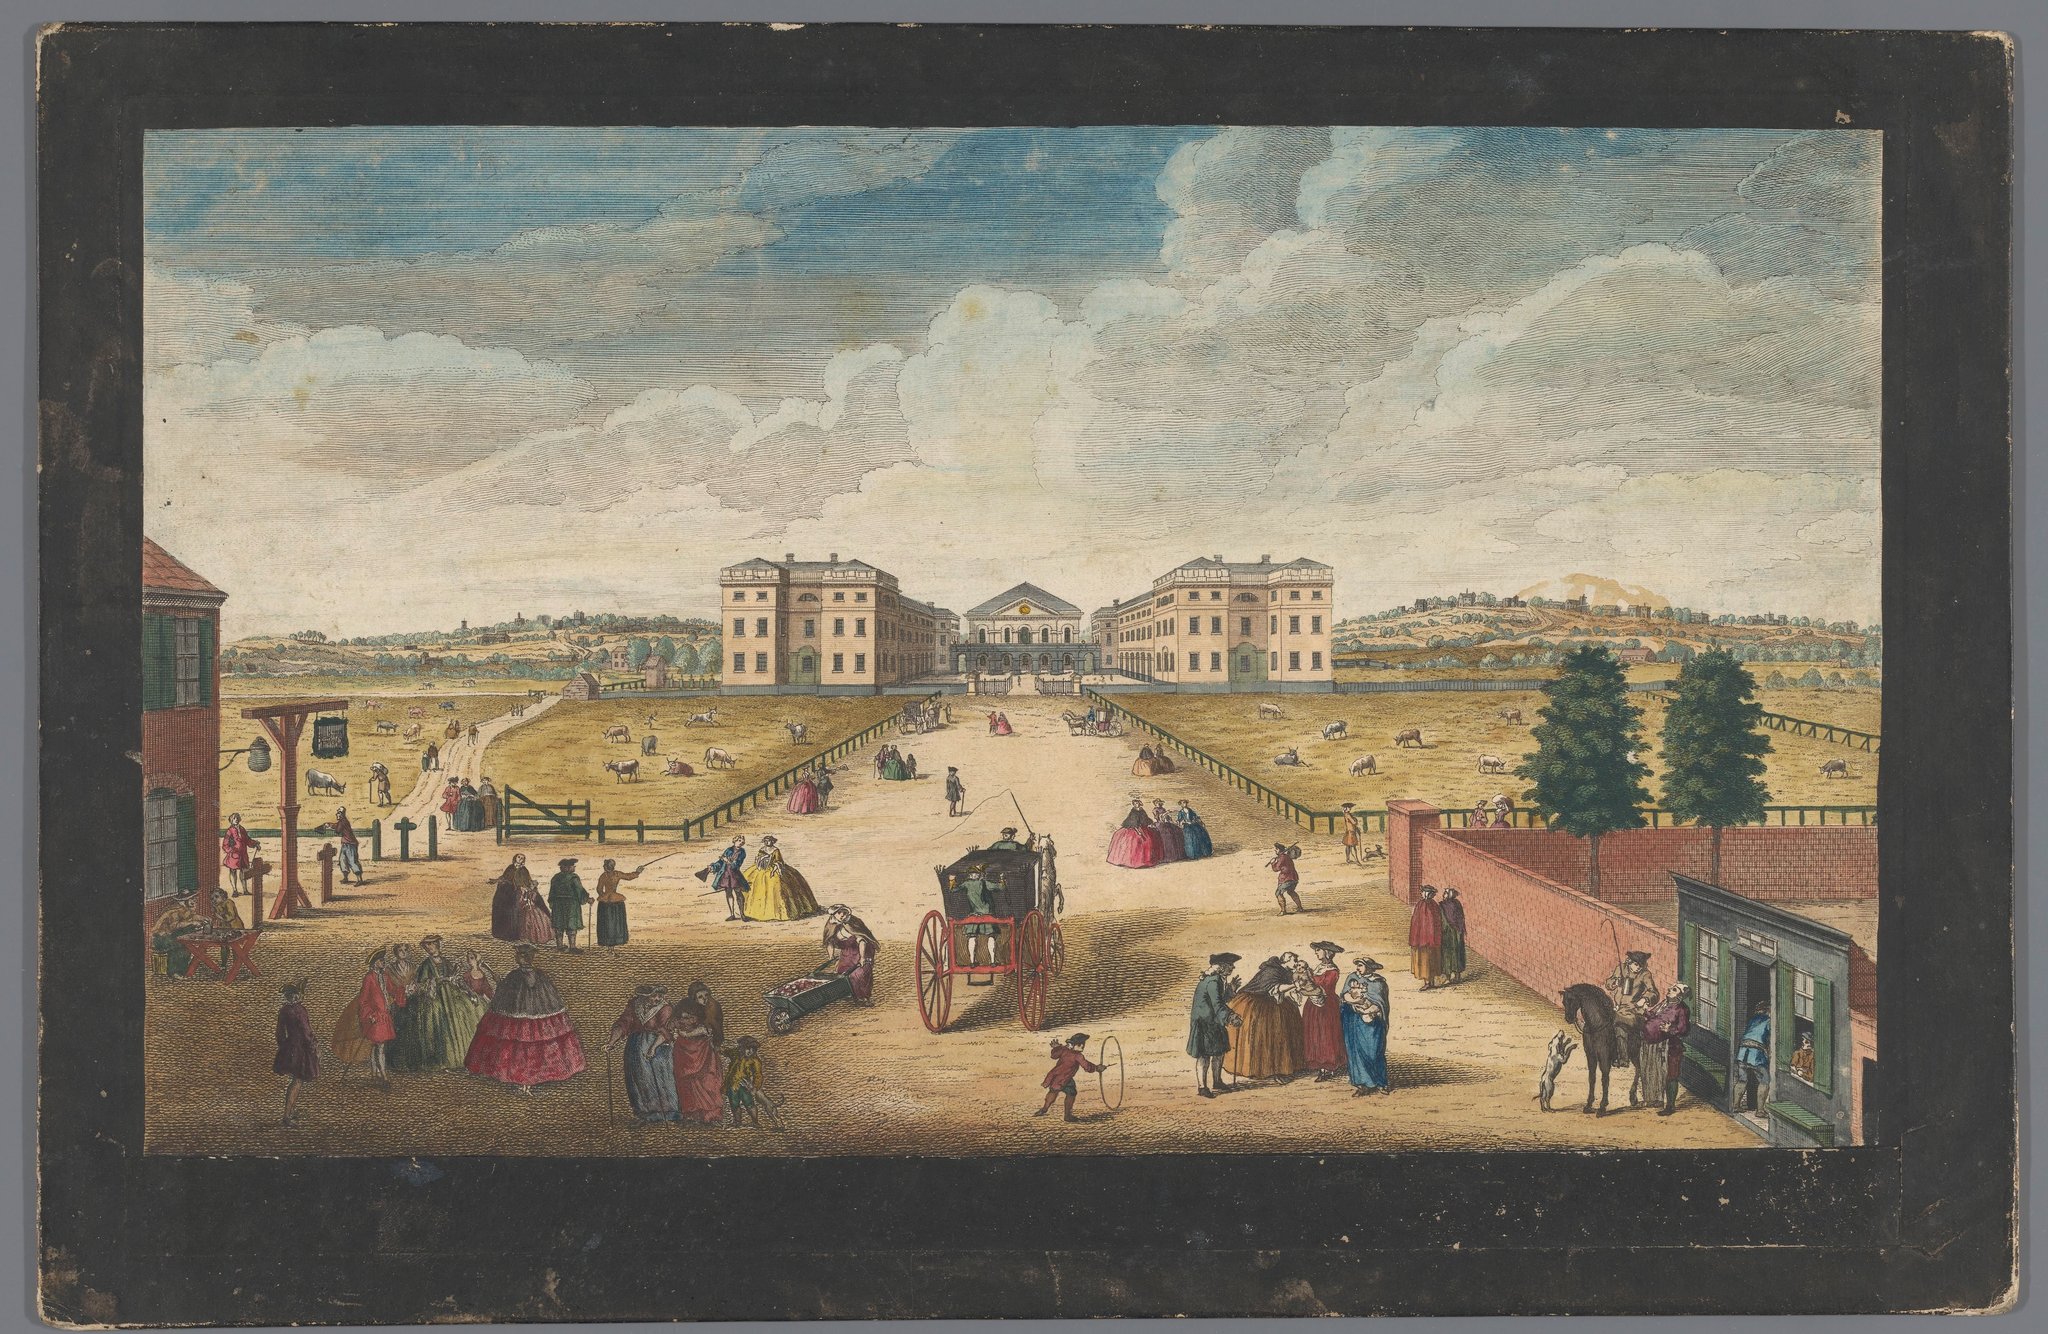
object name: print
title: Gezicht op het Foundling Hospital te Londen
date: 1751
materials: cardboard, paper, watercolor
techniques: brush, etching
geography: england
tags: hospital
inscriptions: collector's mark: Lugt 2233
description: De serie “Londen” bevat 52 prenten met de nummers 1-52, waarvan dit nummer 38 is.